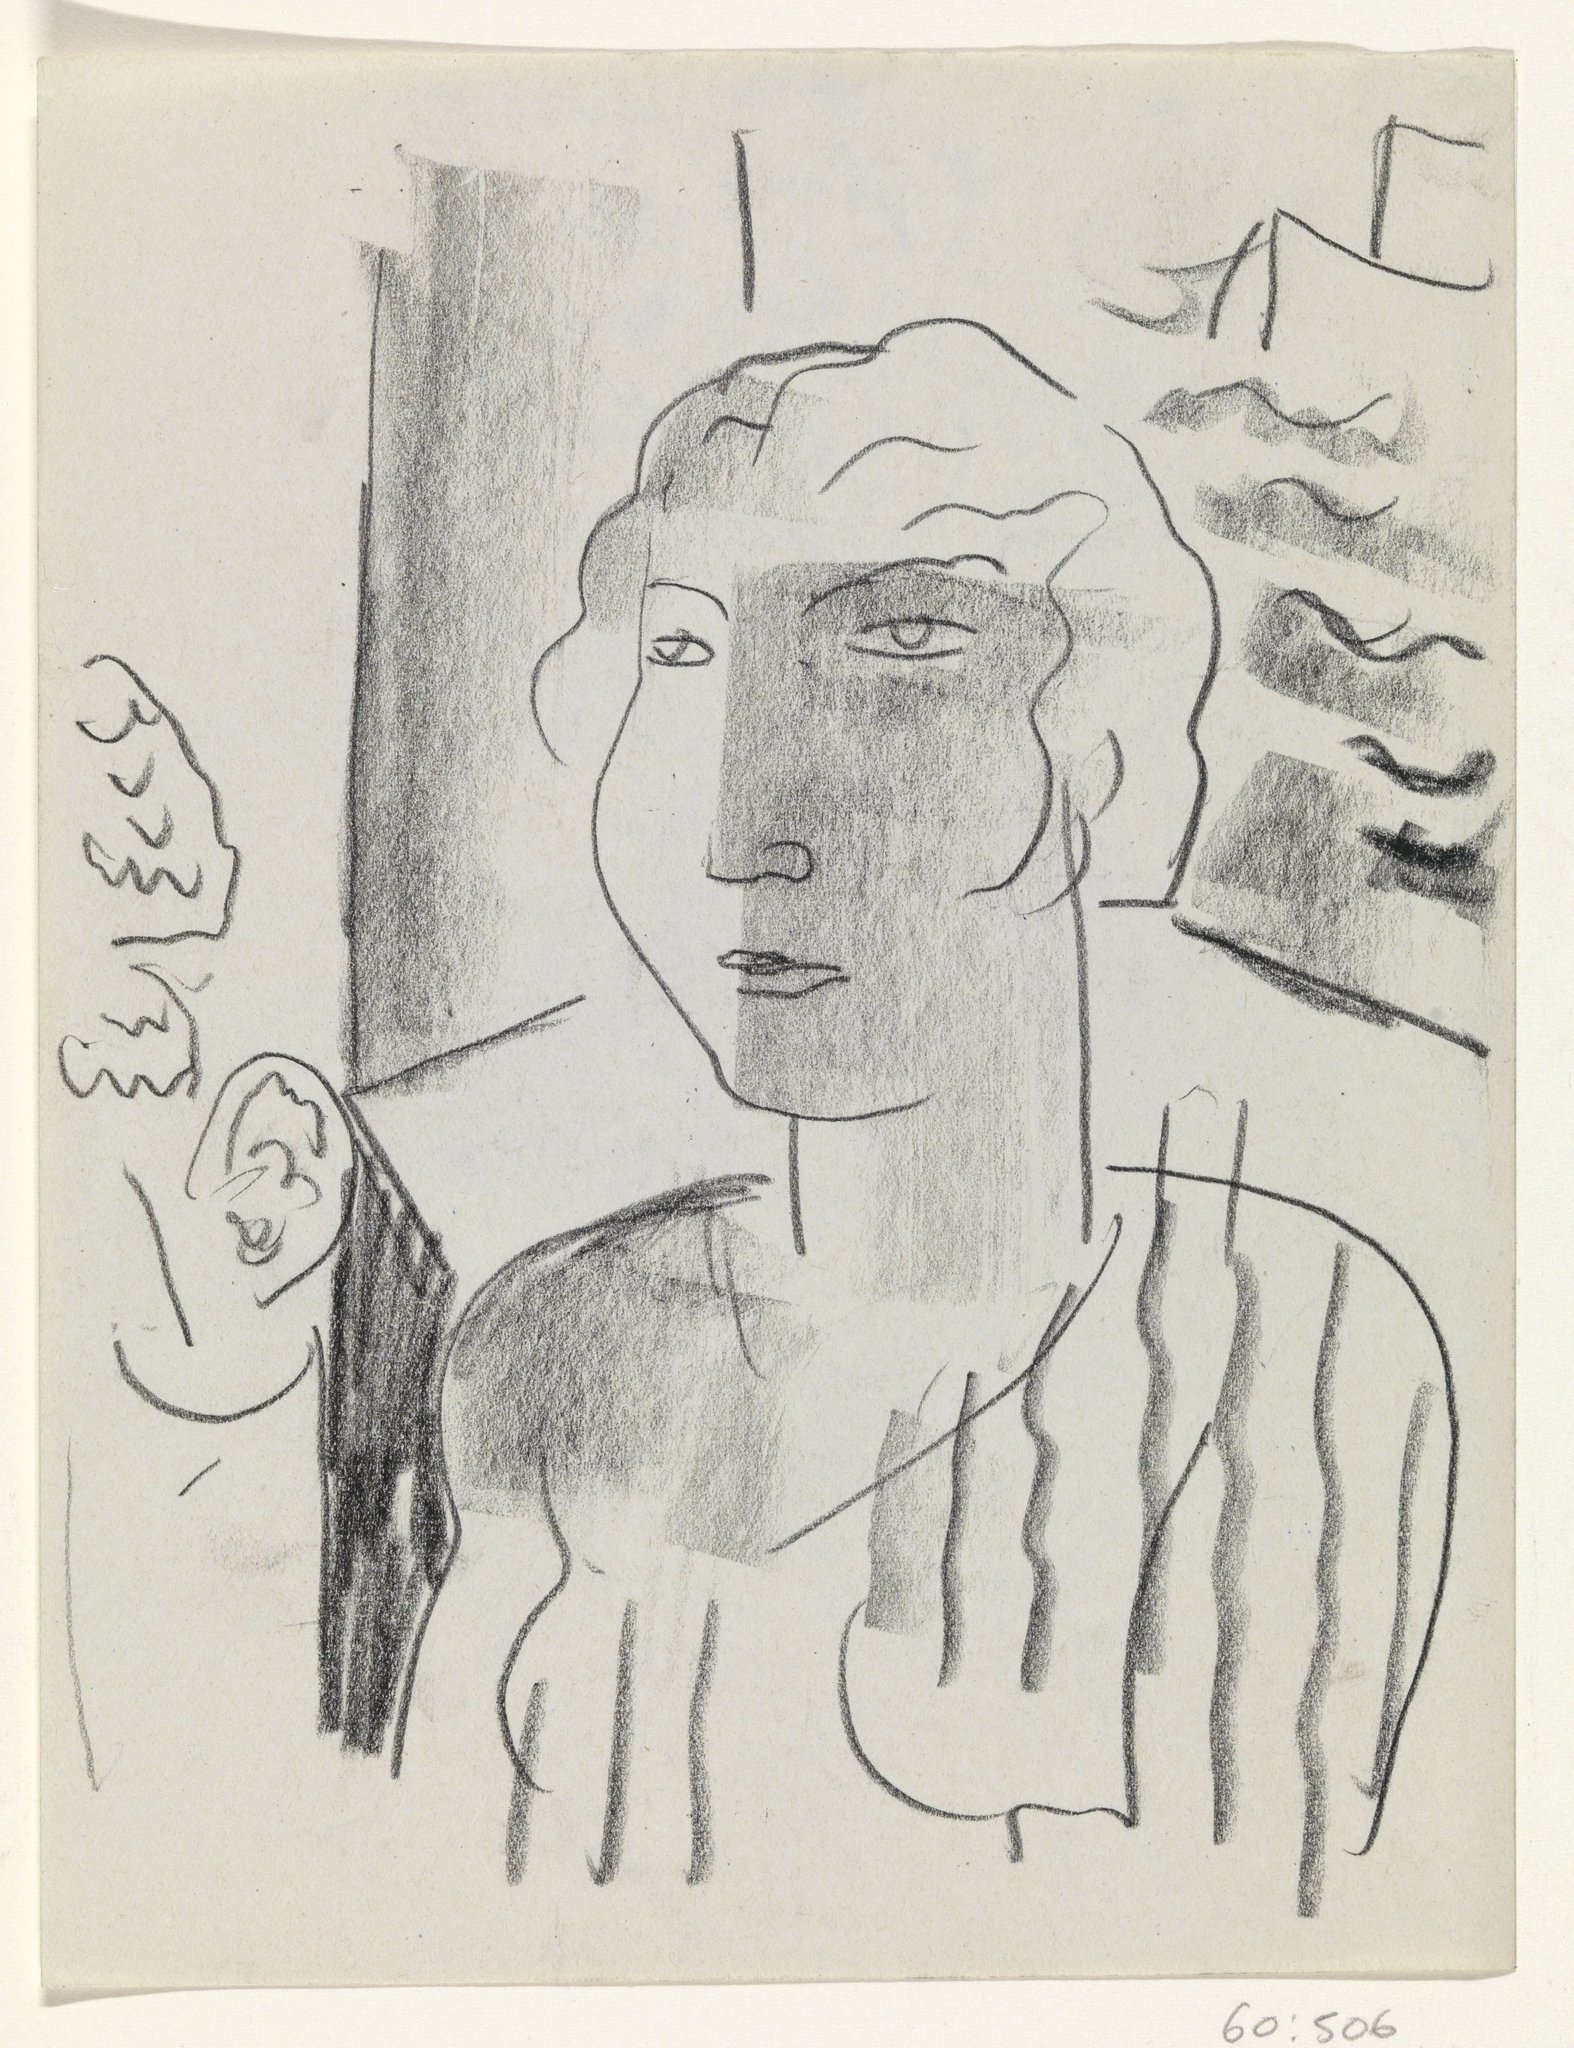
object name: drawing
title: Staande vrouw voor een raam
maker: leo gestel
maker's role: draughtsman, print maker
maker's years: 1881-1941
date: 1891-1941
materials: chalk, paper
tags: window, female sex; woman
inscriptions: collector's mark: Lugt 2228